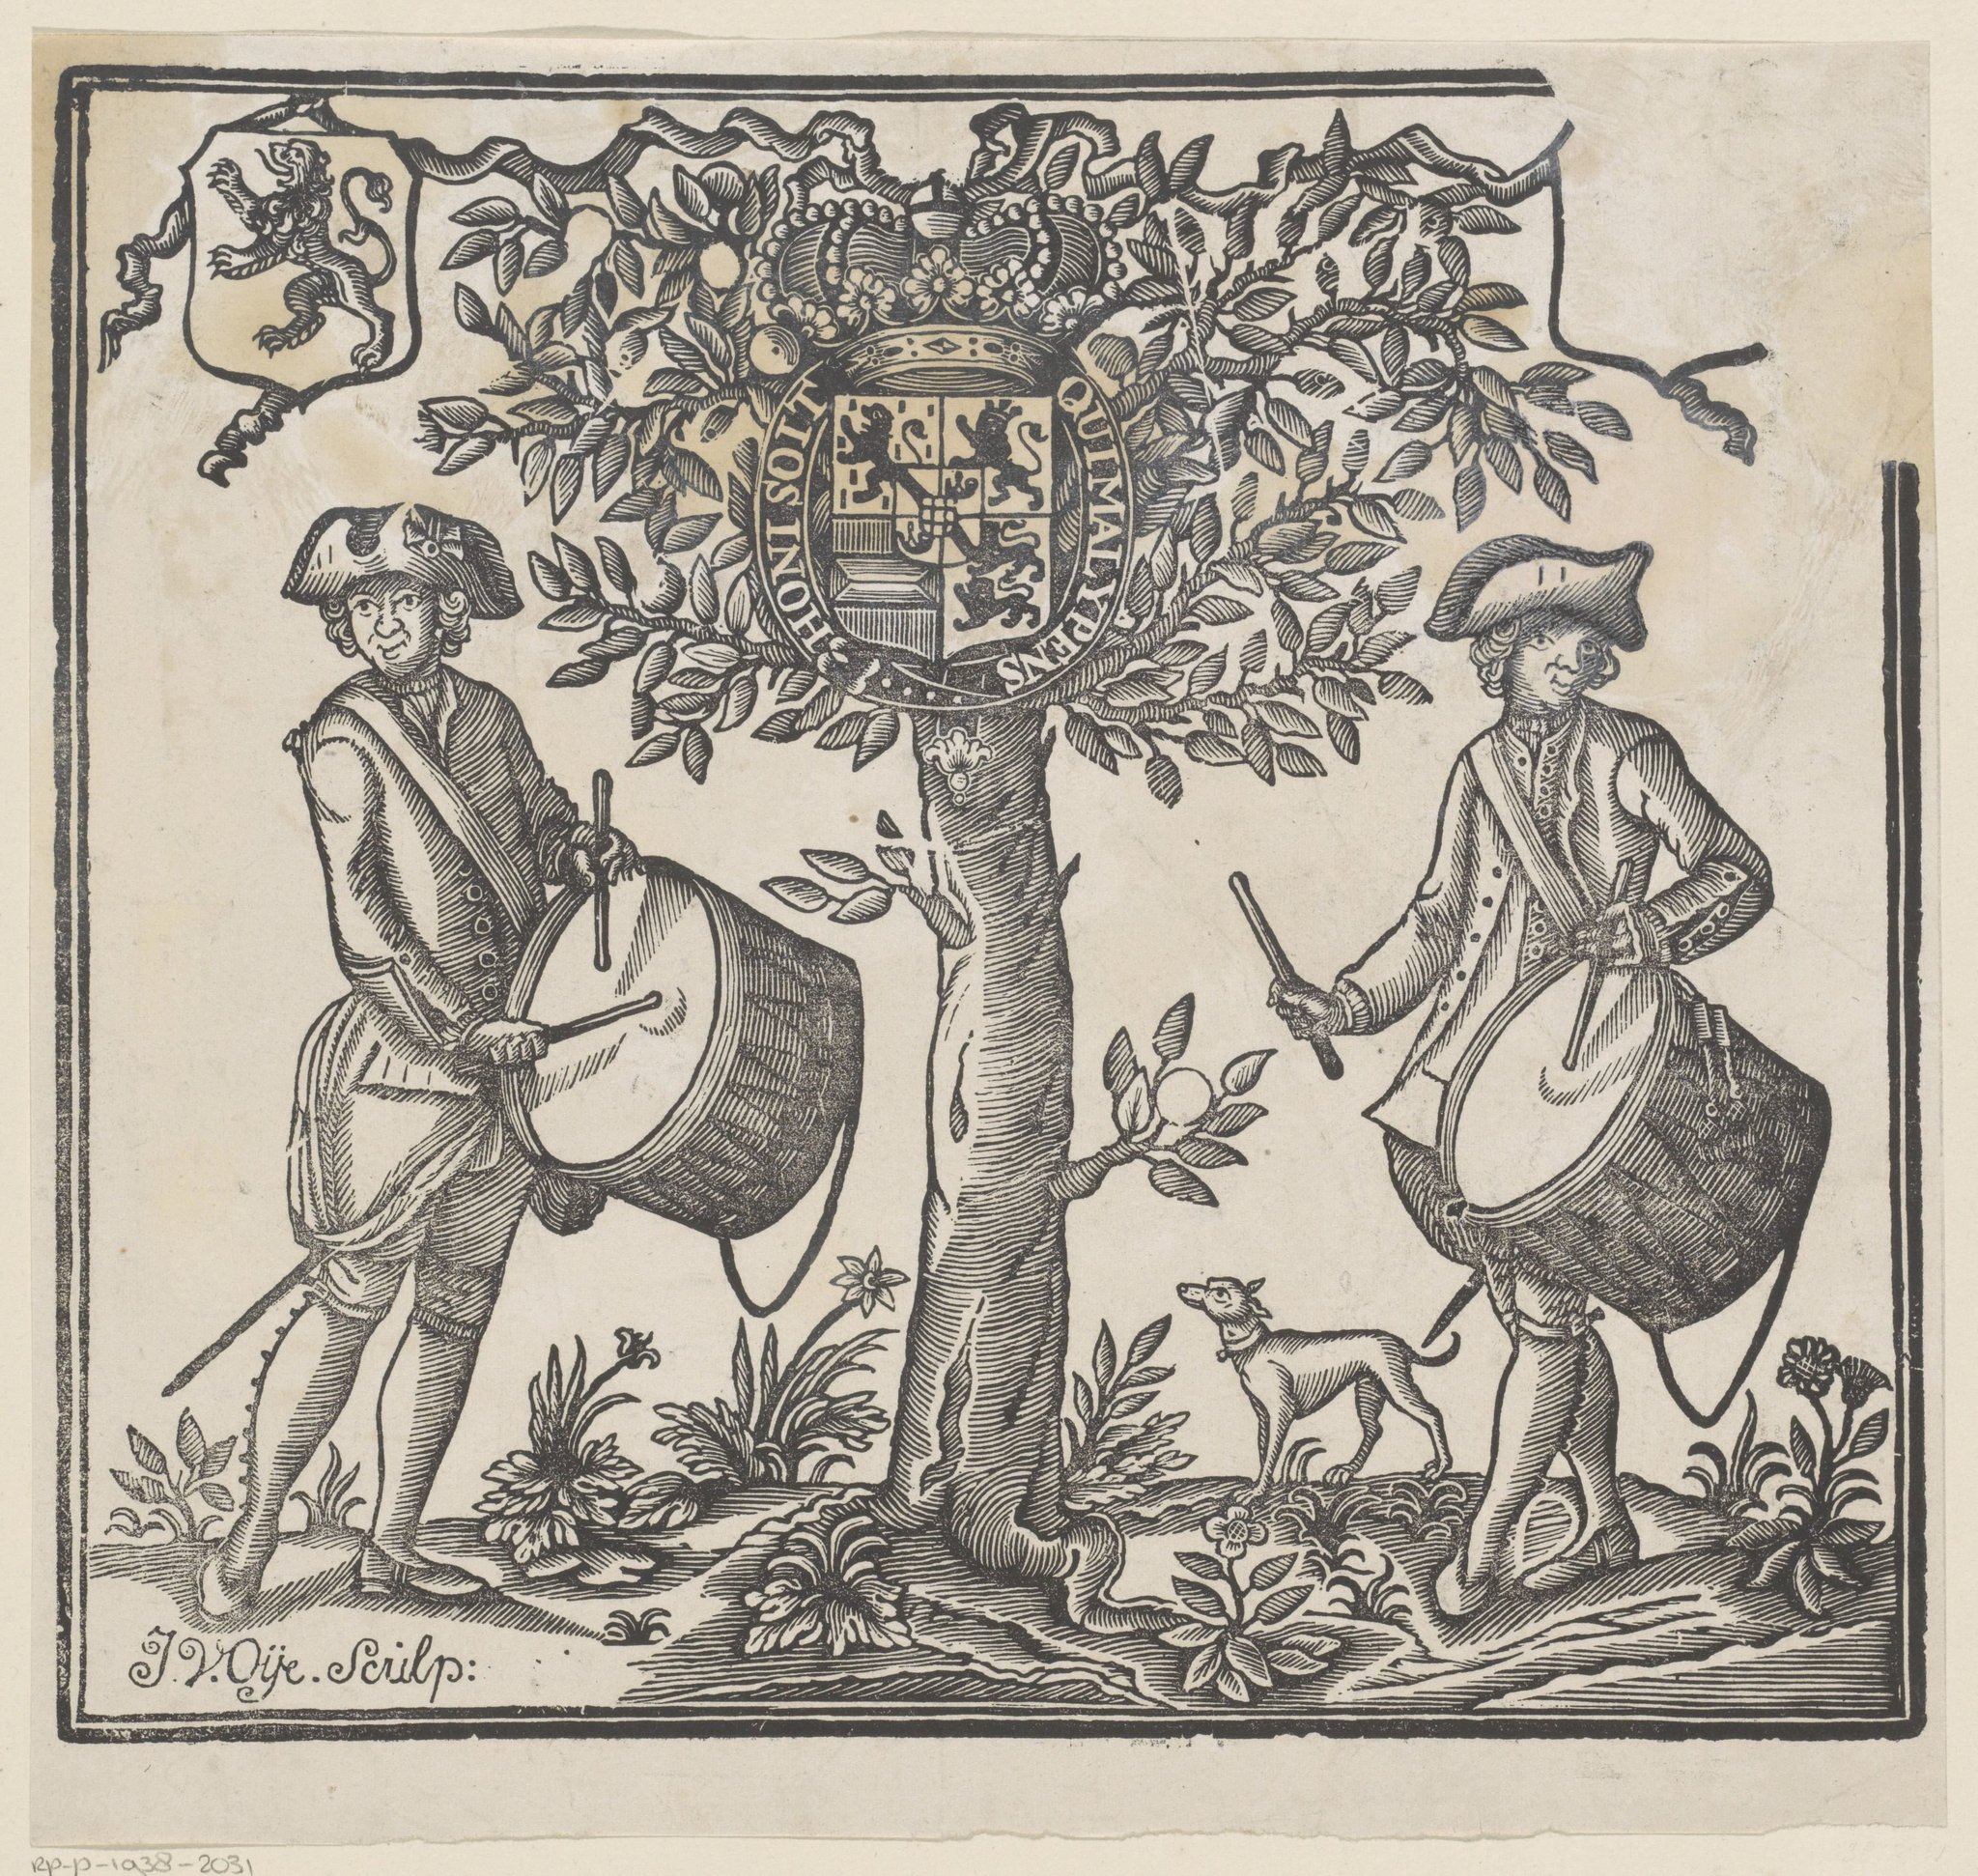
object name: print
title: Twee tamboers onder een oranjeboom met drie wapens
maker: j. van oye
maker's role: print maker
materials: paper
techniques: woodcut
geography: netherlands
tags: coat of arms (as symbol of the state, etc.), trees: orange-tree, drum (musical instrument)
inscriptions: collector's mark: Lugt 2760